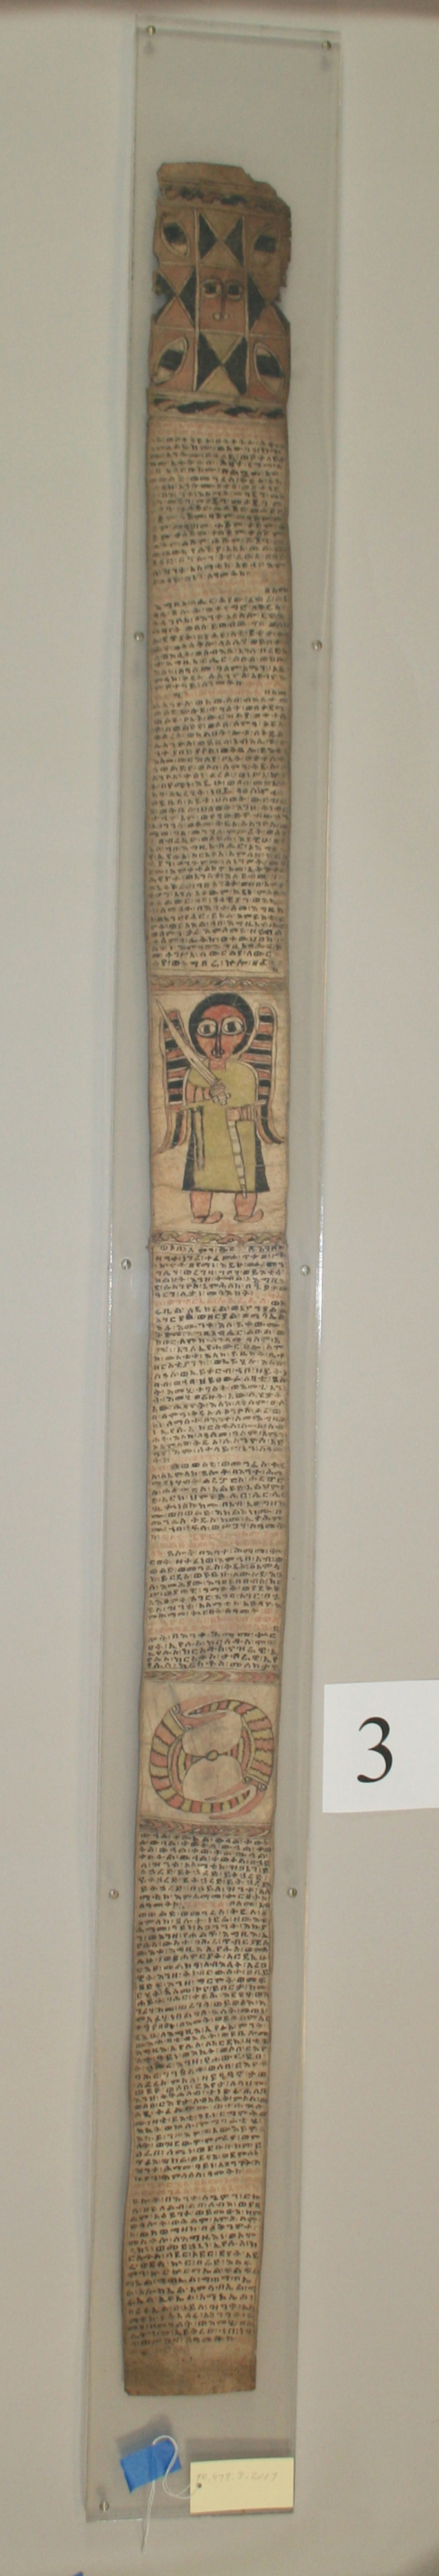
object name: scroll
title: Healing Scroll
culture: amhara or tigrinya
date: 1801-1900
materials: parchment, pigment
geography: ethiopia